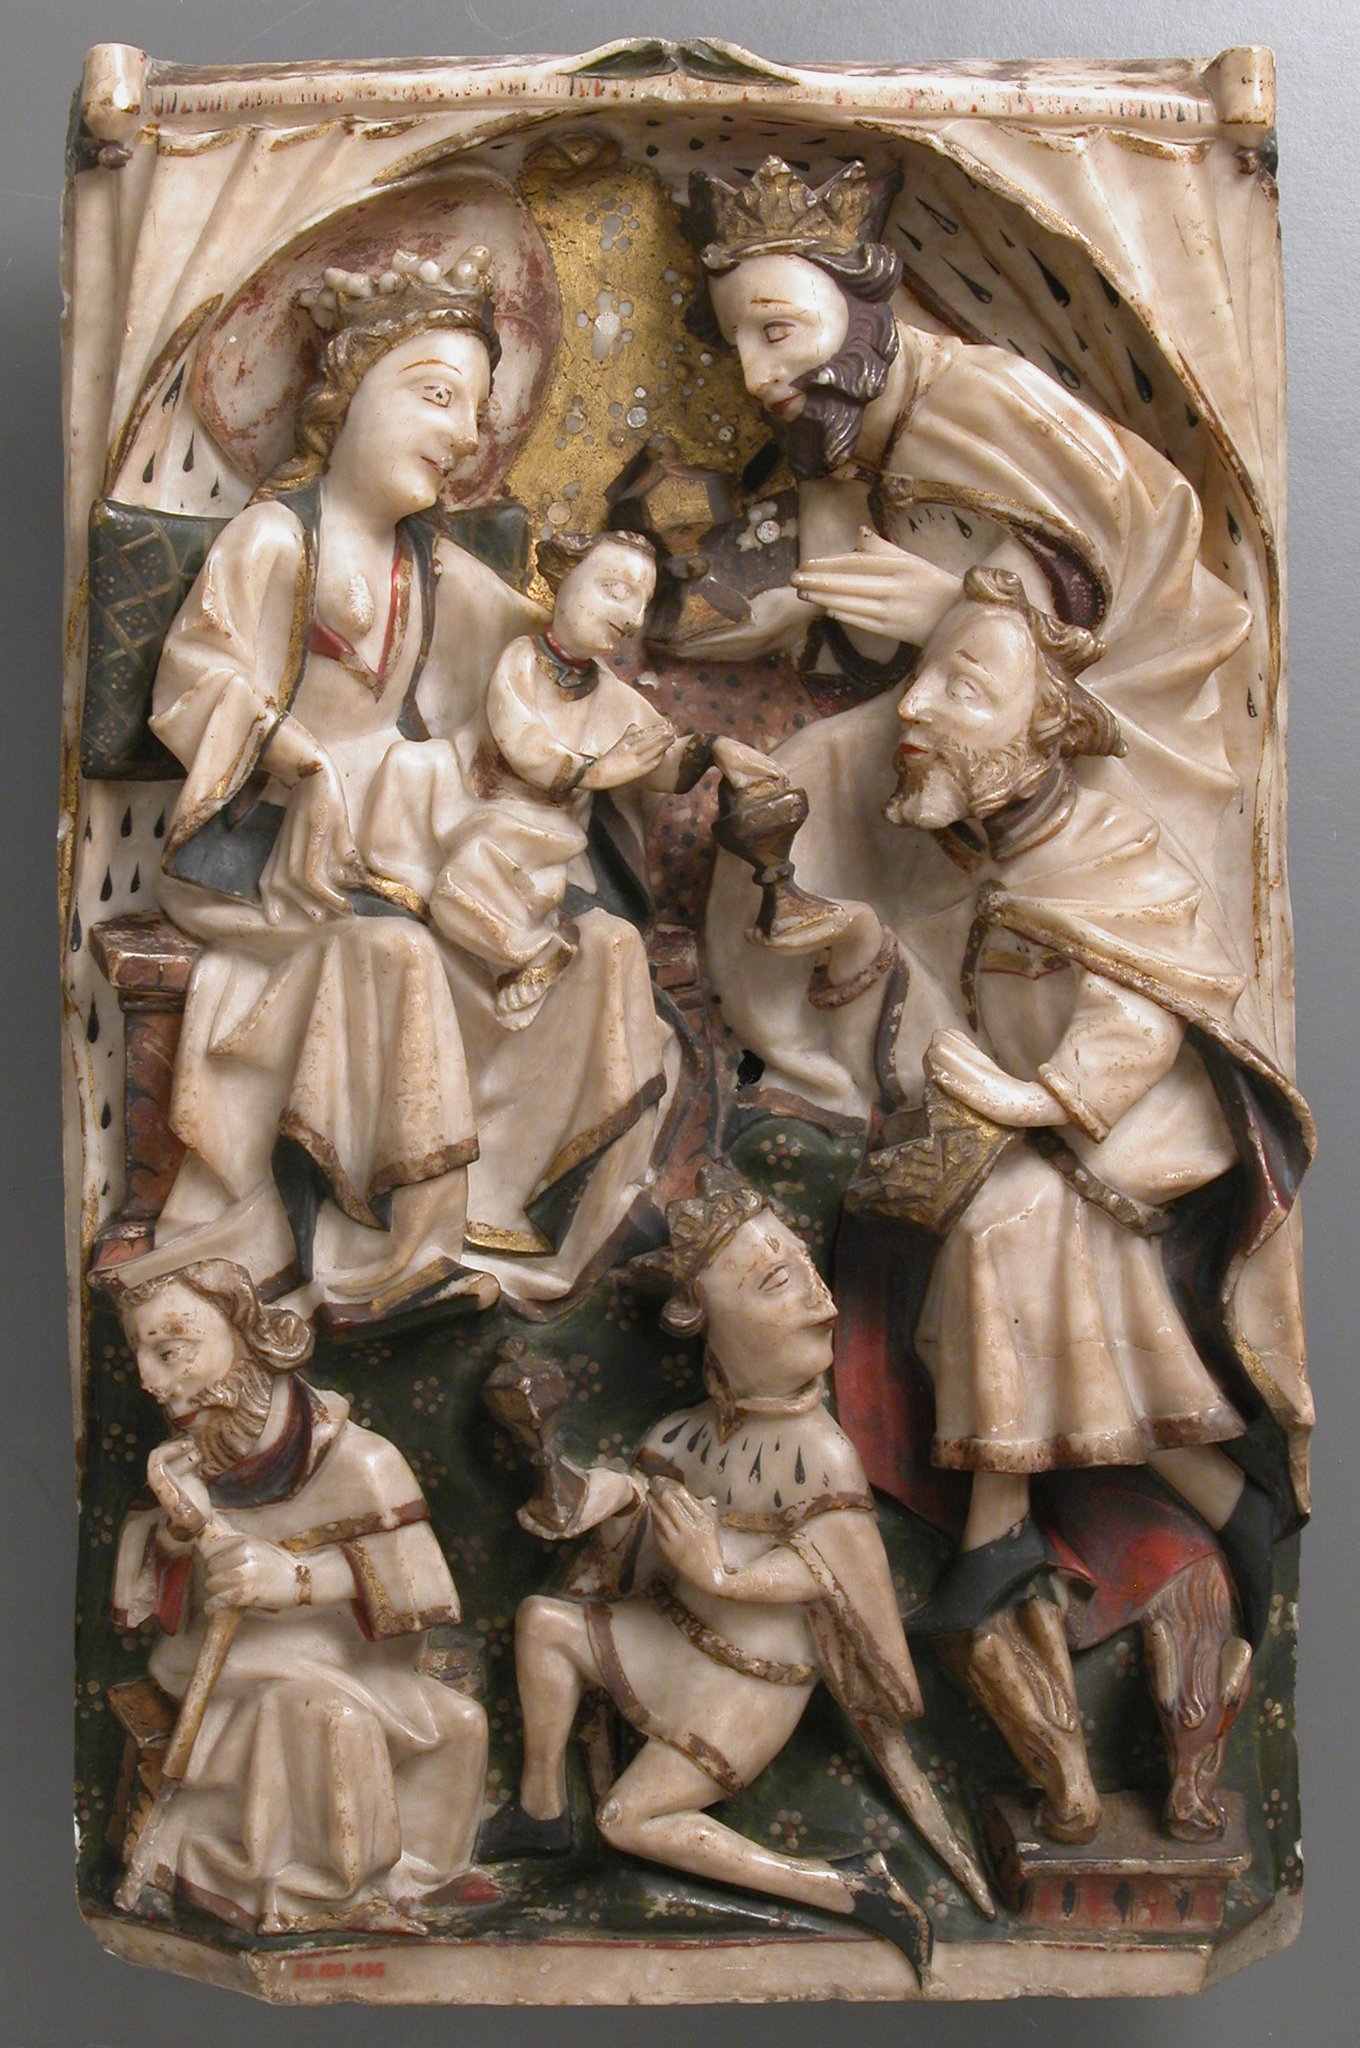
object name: relief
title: Adoration of the Magi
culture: british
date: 1451-1500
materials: alabaster, paint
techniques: gilding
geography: england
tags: men,virgin mary,jesus,adoration of the magi